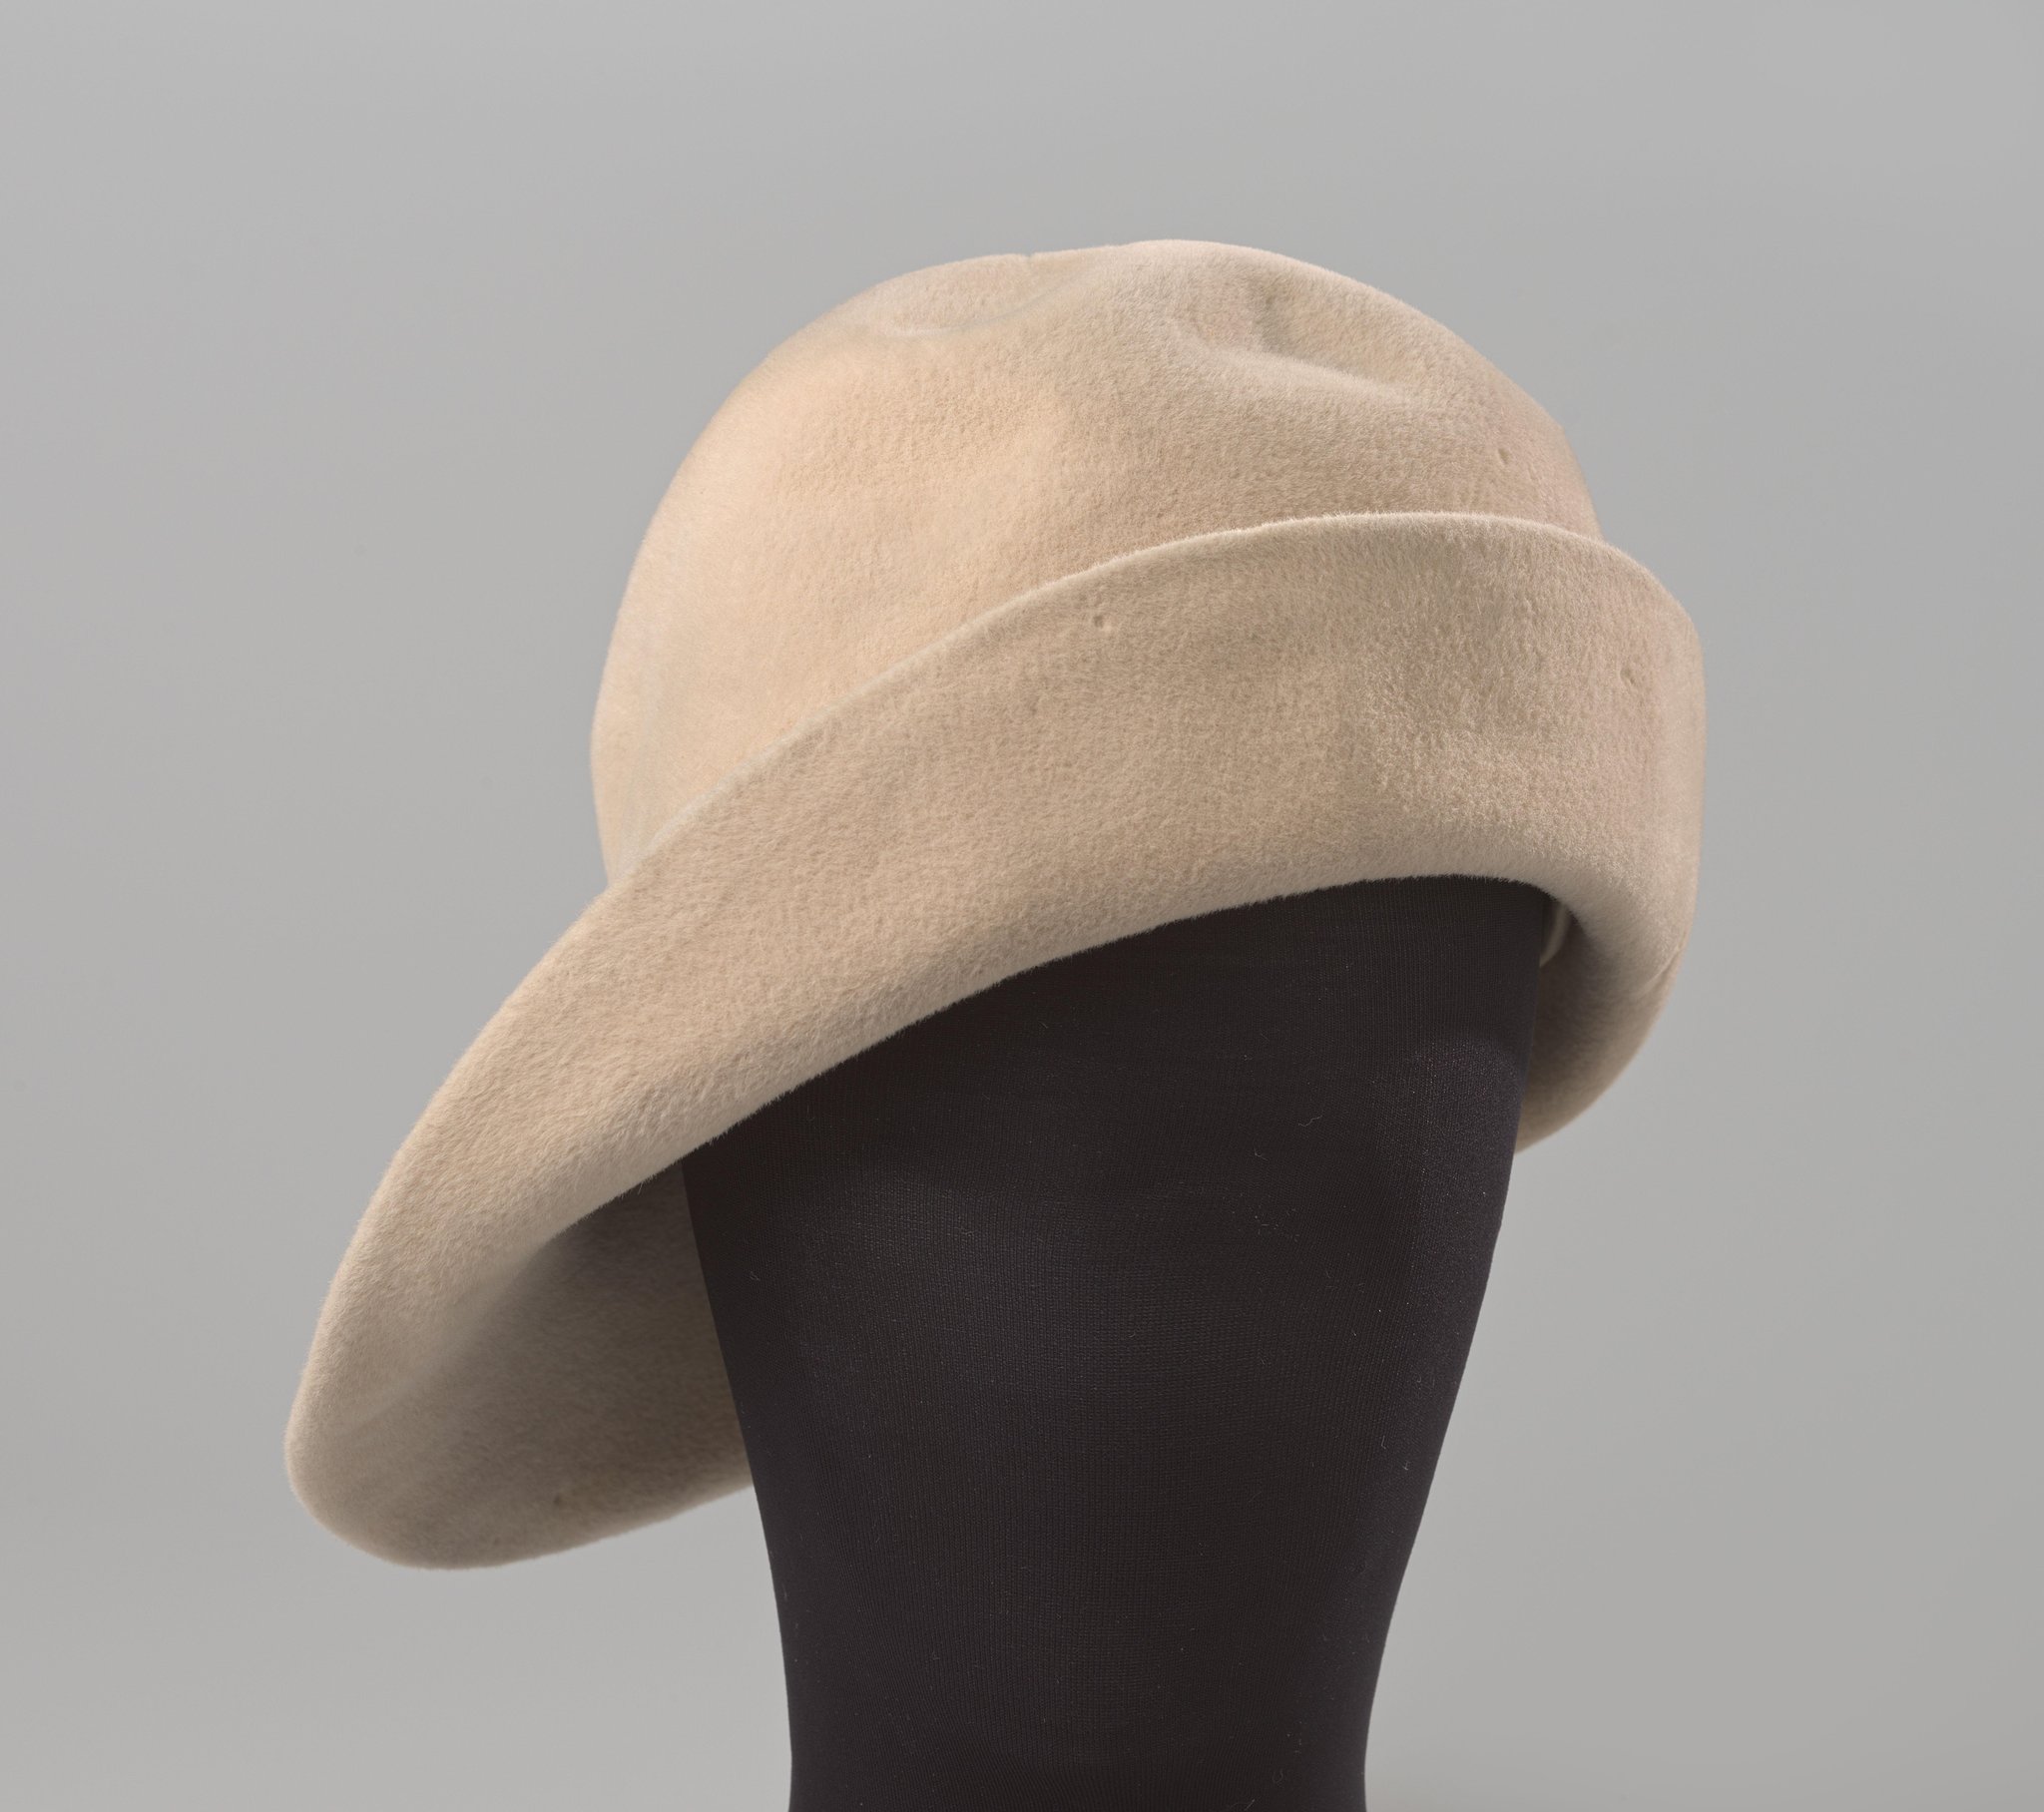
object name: hat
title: Hoed van zandkleurig haarvilt, ongevoerd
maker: christian dior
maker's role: modeontwerper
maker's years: 1905-1957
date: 1920-1993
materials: felt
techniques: haarvilt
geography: paris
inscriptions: mark: ‘Christian Dior / PARIS / MADE IN / FRANCE’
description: Hoed van zandkleurig haarvilt, ongevoerd.